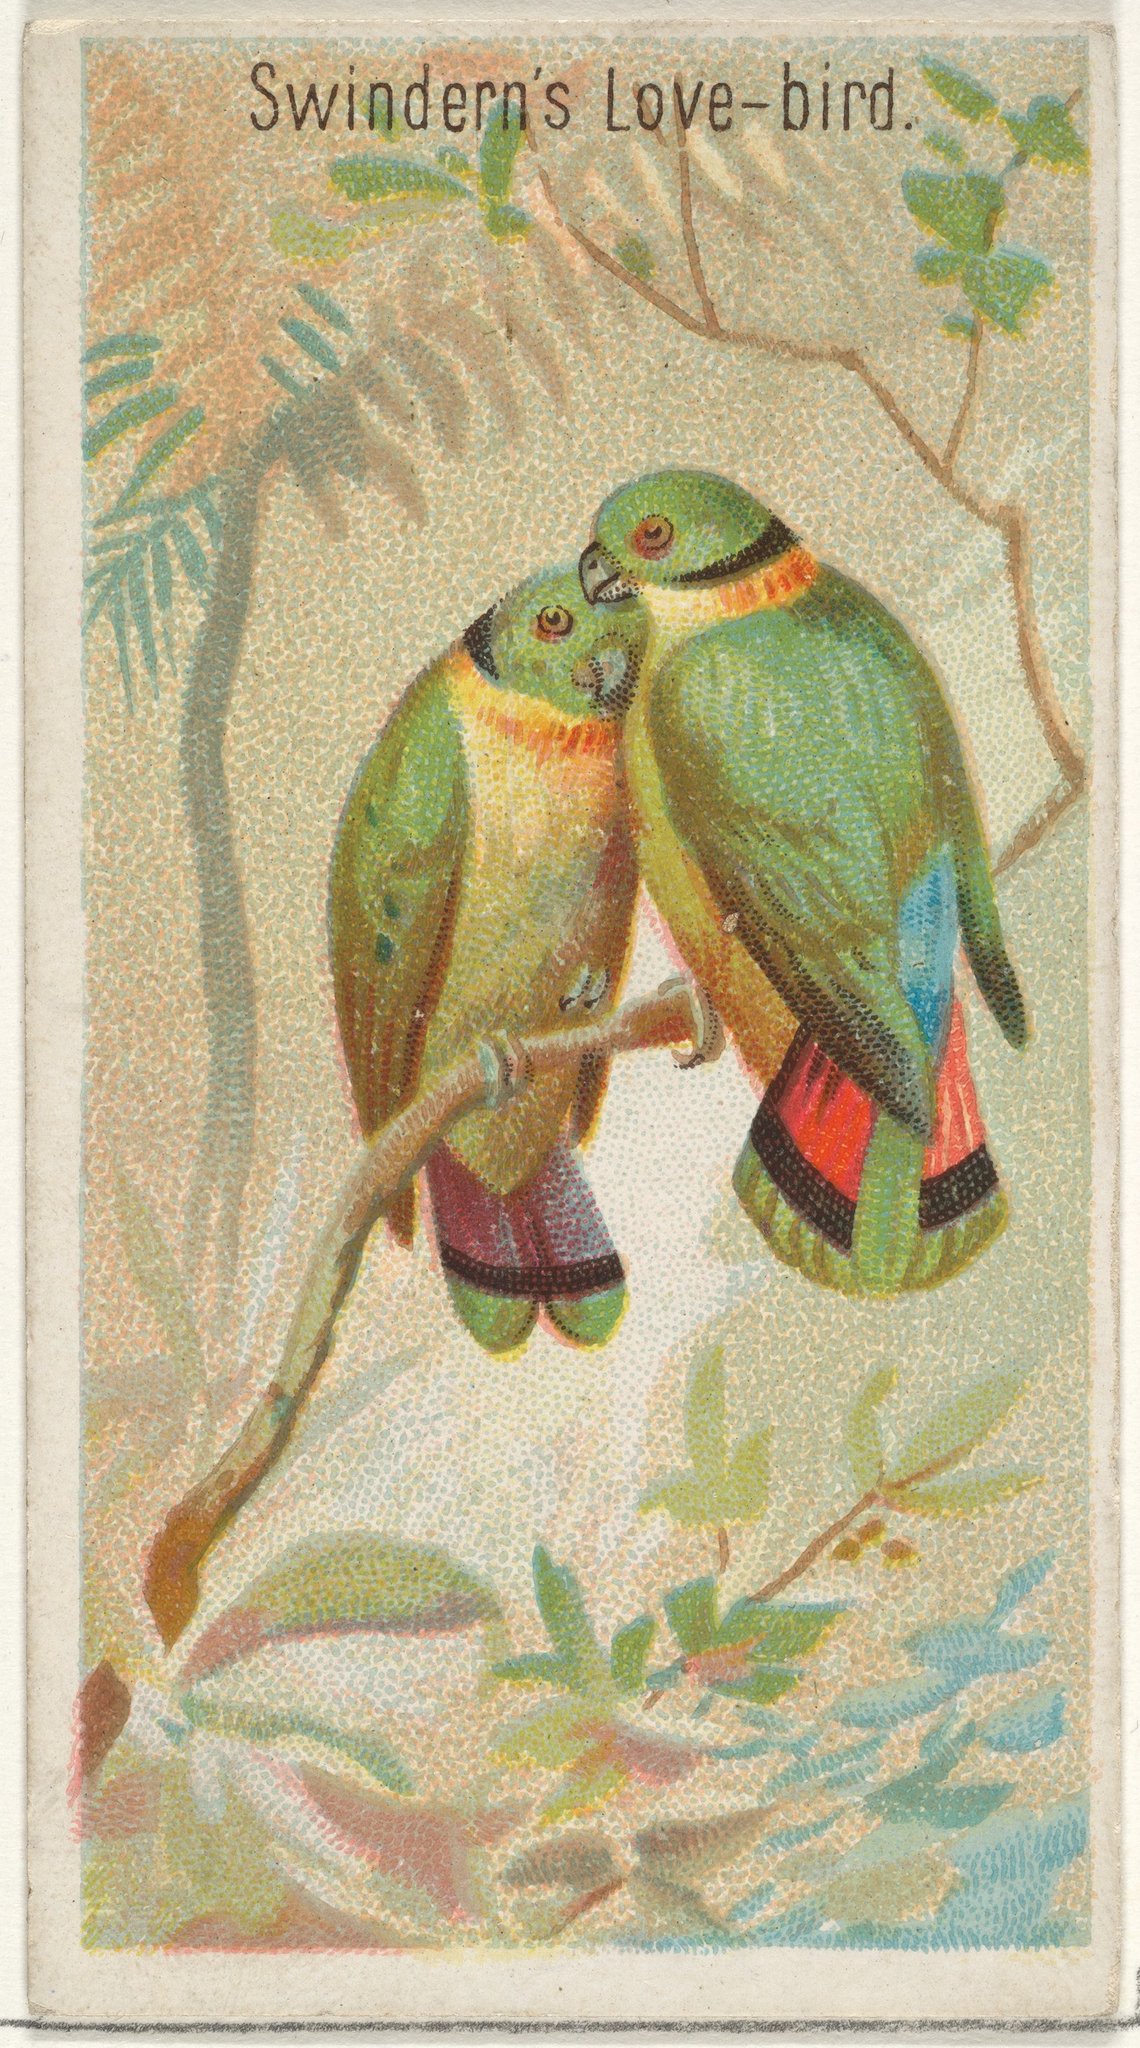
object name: print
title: Swindern's Love-Bird, from the Birds of the Tropics series (N5) for Allen & Ginter Cigarettes Brands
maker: allen & ginter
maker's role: publisher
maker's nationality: american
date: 1889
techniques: color lithograph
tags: birds